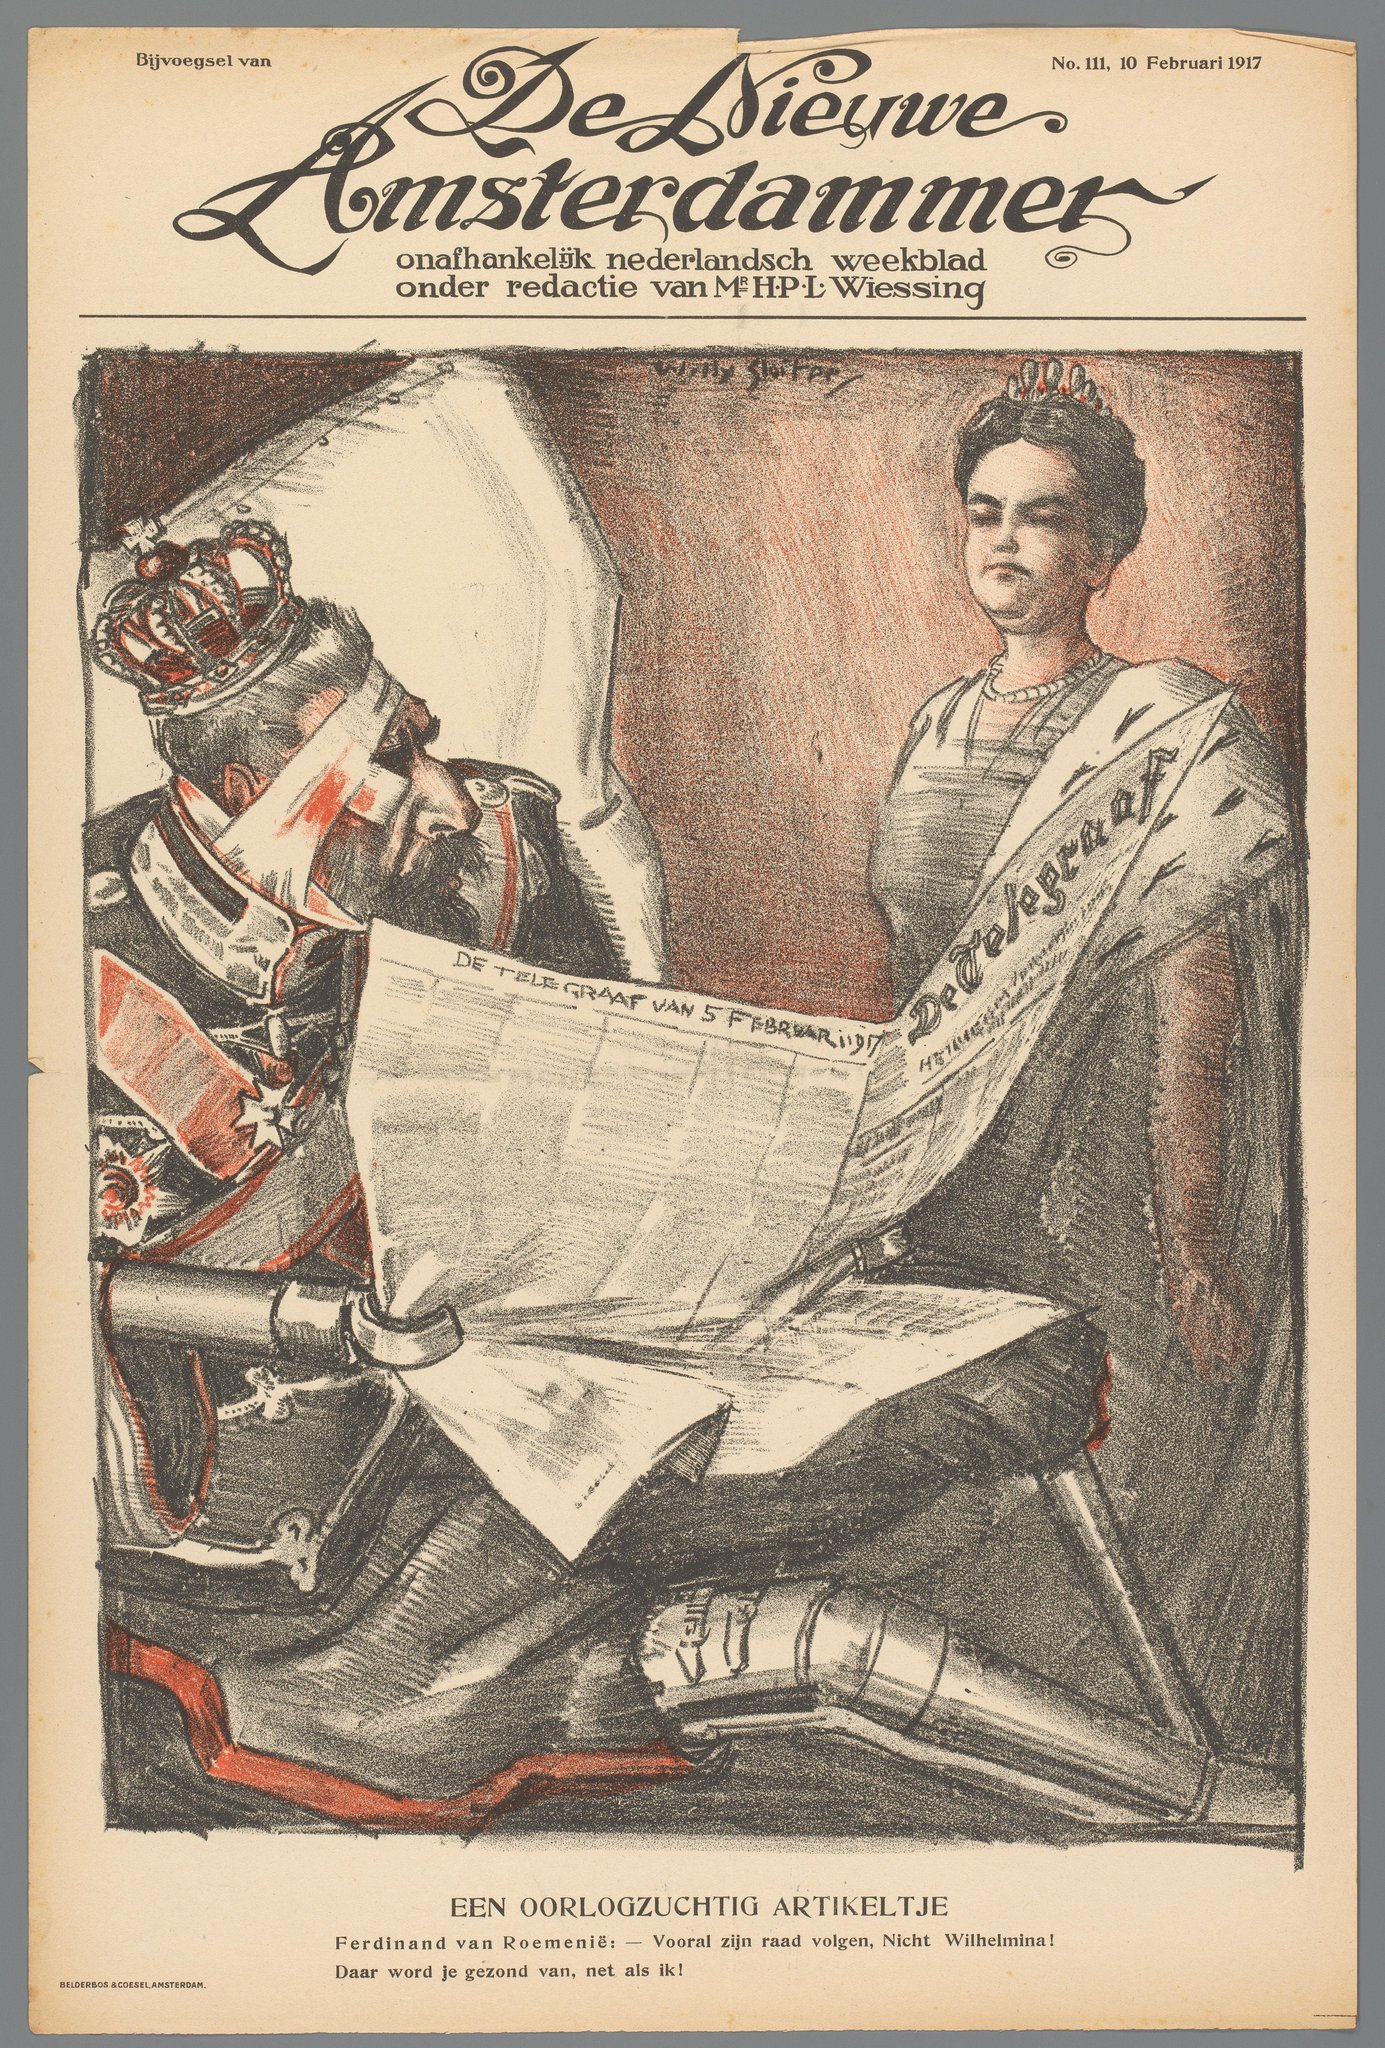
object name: print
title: Een oorlogzuchtige artikeltje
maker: willy sluiter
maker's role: draughtsman, painter, print maker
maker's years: 1873-1949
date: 1917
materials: paper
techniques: lithograph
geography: netherlands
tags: the hague, print maker, wilhelmina of the netherlands, newspaper, news-sheet, political caricatures and satires, netherlands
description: Een aangeslagen en zwaar gewonde koning Ferdinand van Roemenië leest een artikel in de krant De Telegraaf van 5 februari en adviseert koningin Wilhelmina, Spotprent over de Eerste Wereldoorlog, 10 februari 1917.